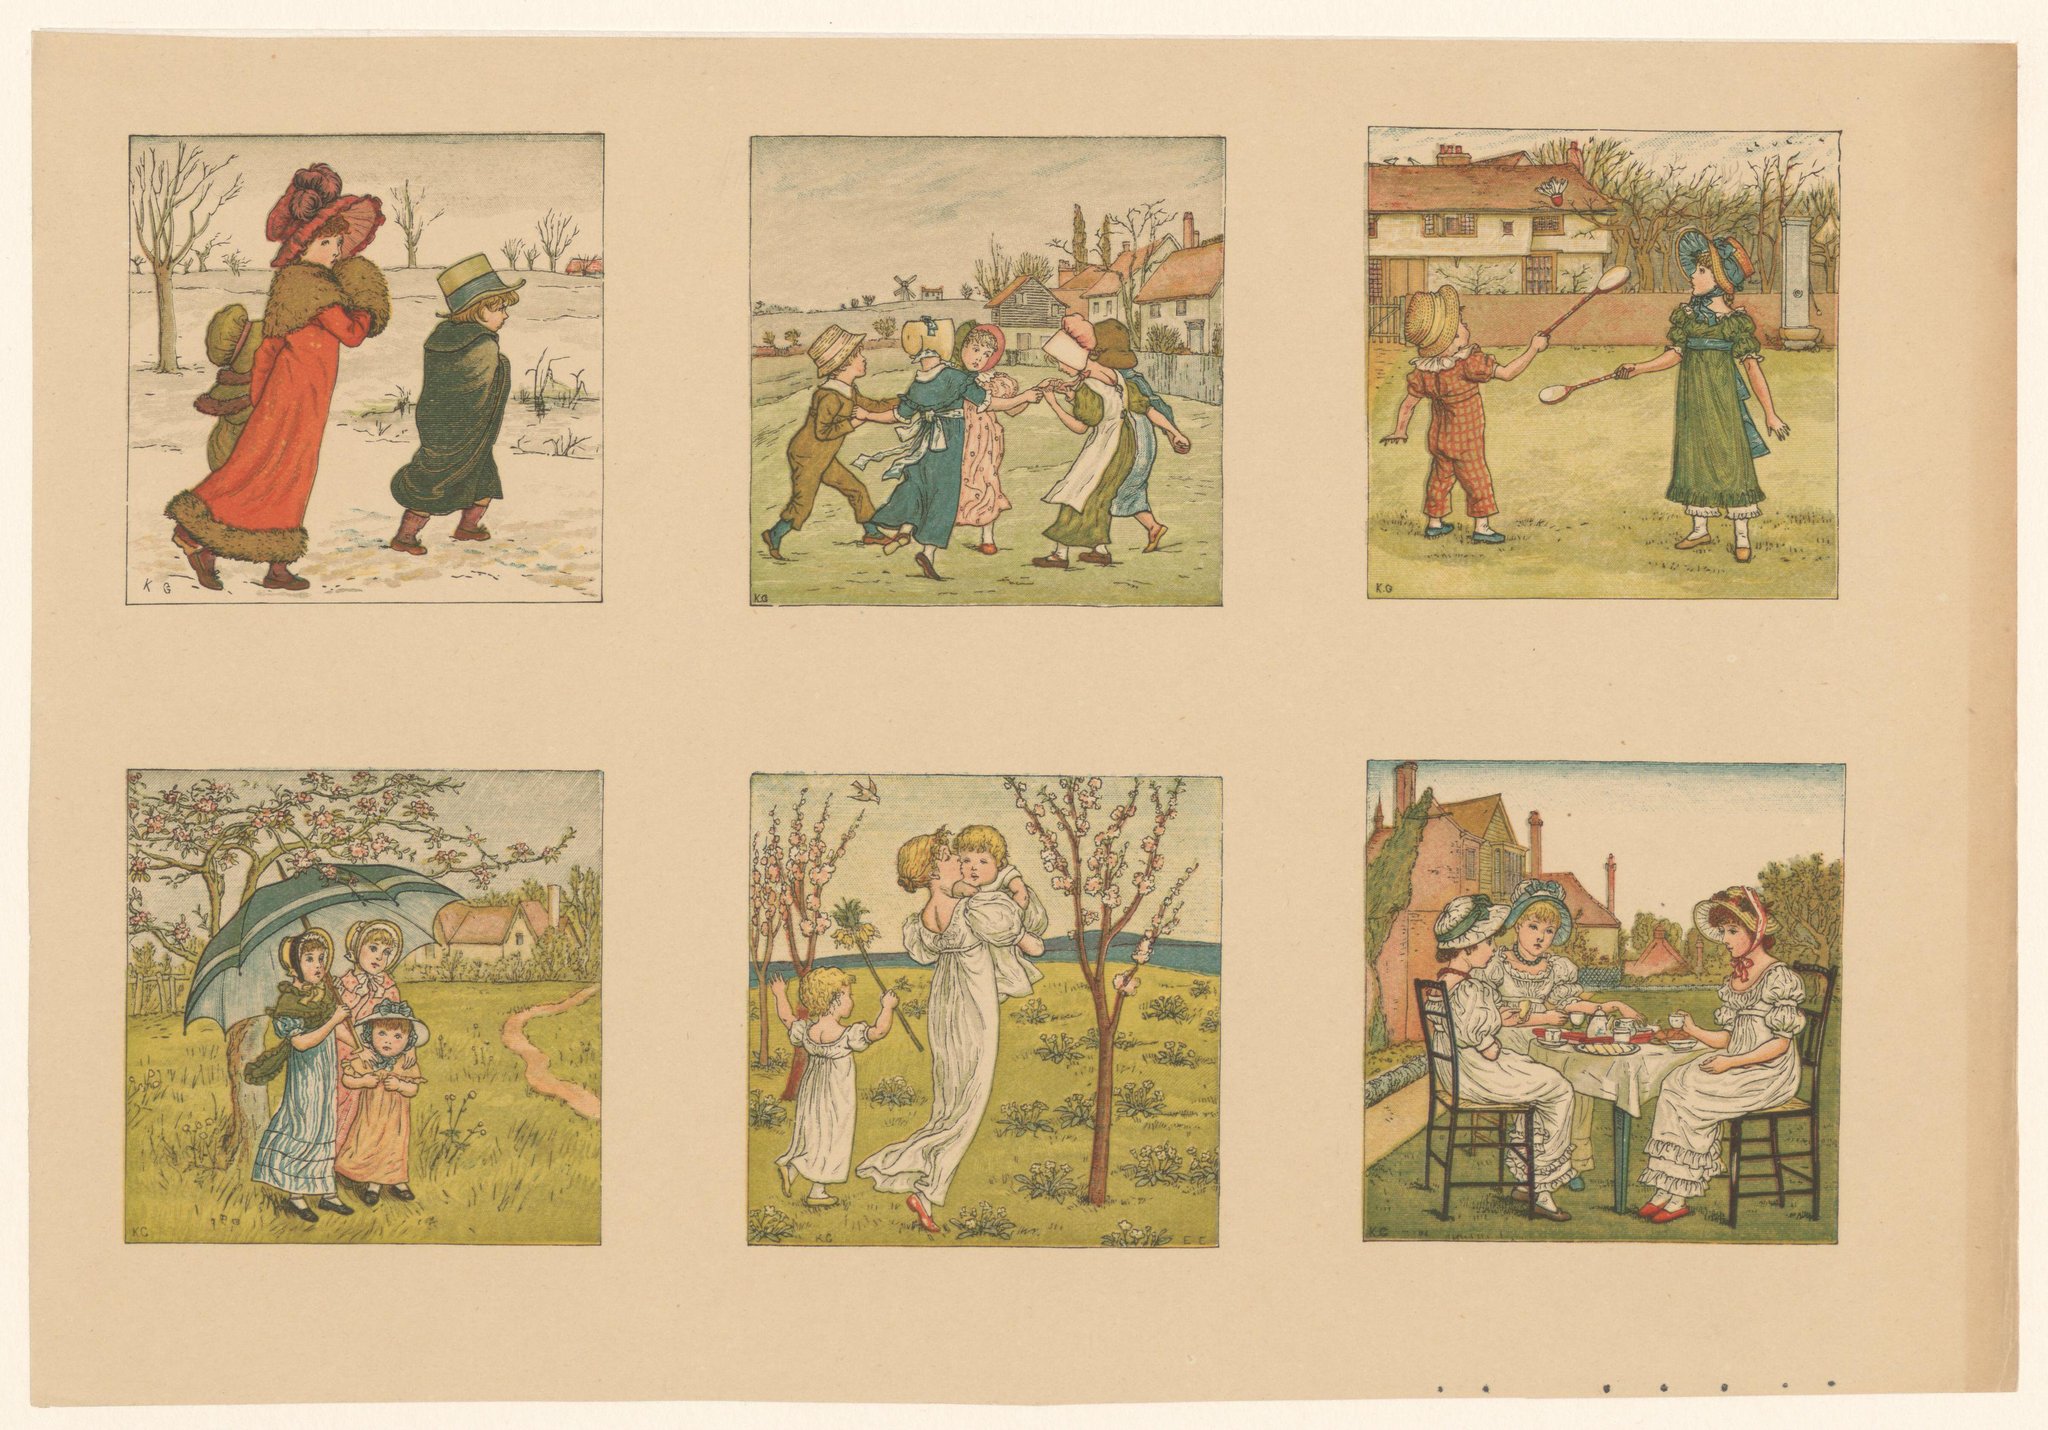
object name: print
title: Zes voorstellingen van kinderen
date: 1880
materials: paper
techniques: wood engraving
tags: children's games and plays, child (+ more than eight persons), landscapes (+ landscape with figures, staffage)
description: De zes voorstellingen zijn afzonderlijk gepubliceerd in: Greenaway, Kate en Sale Barker. Birthday book for children. Londen: George Routledge & Sons, 1880.